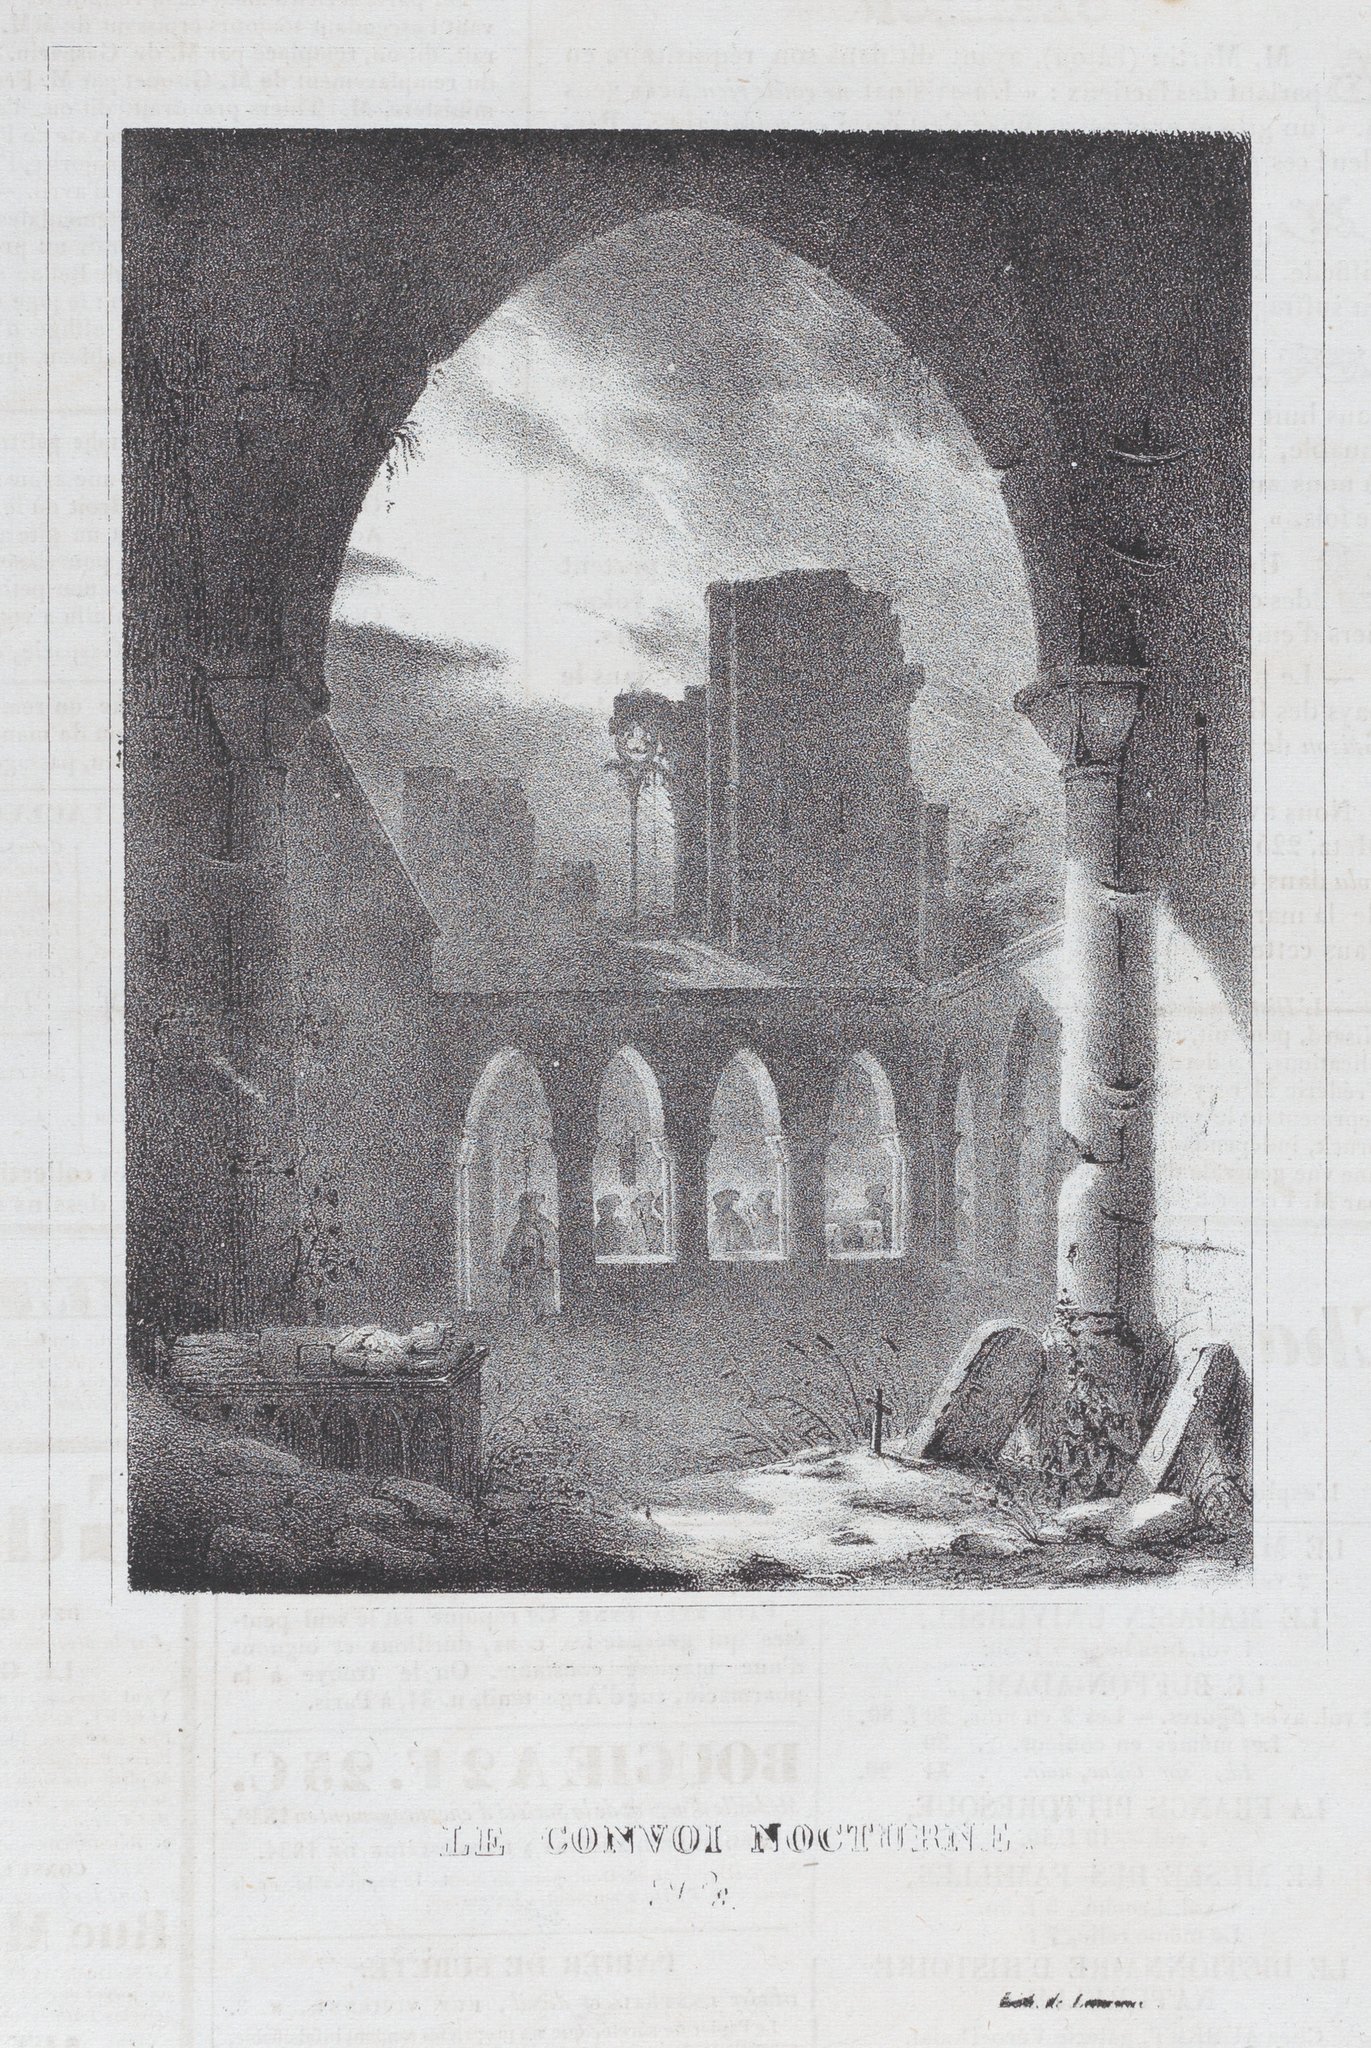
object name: print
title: L'Eglise en Ruines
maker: Anonymous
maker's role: artist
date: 1834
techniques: lithograph